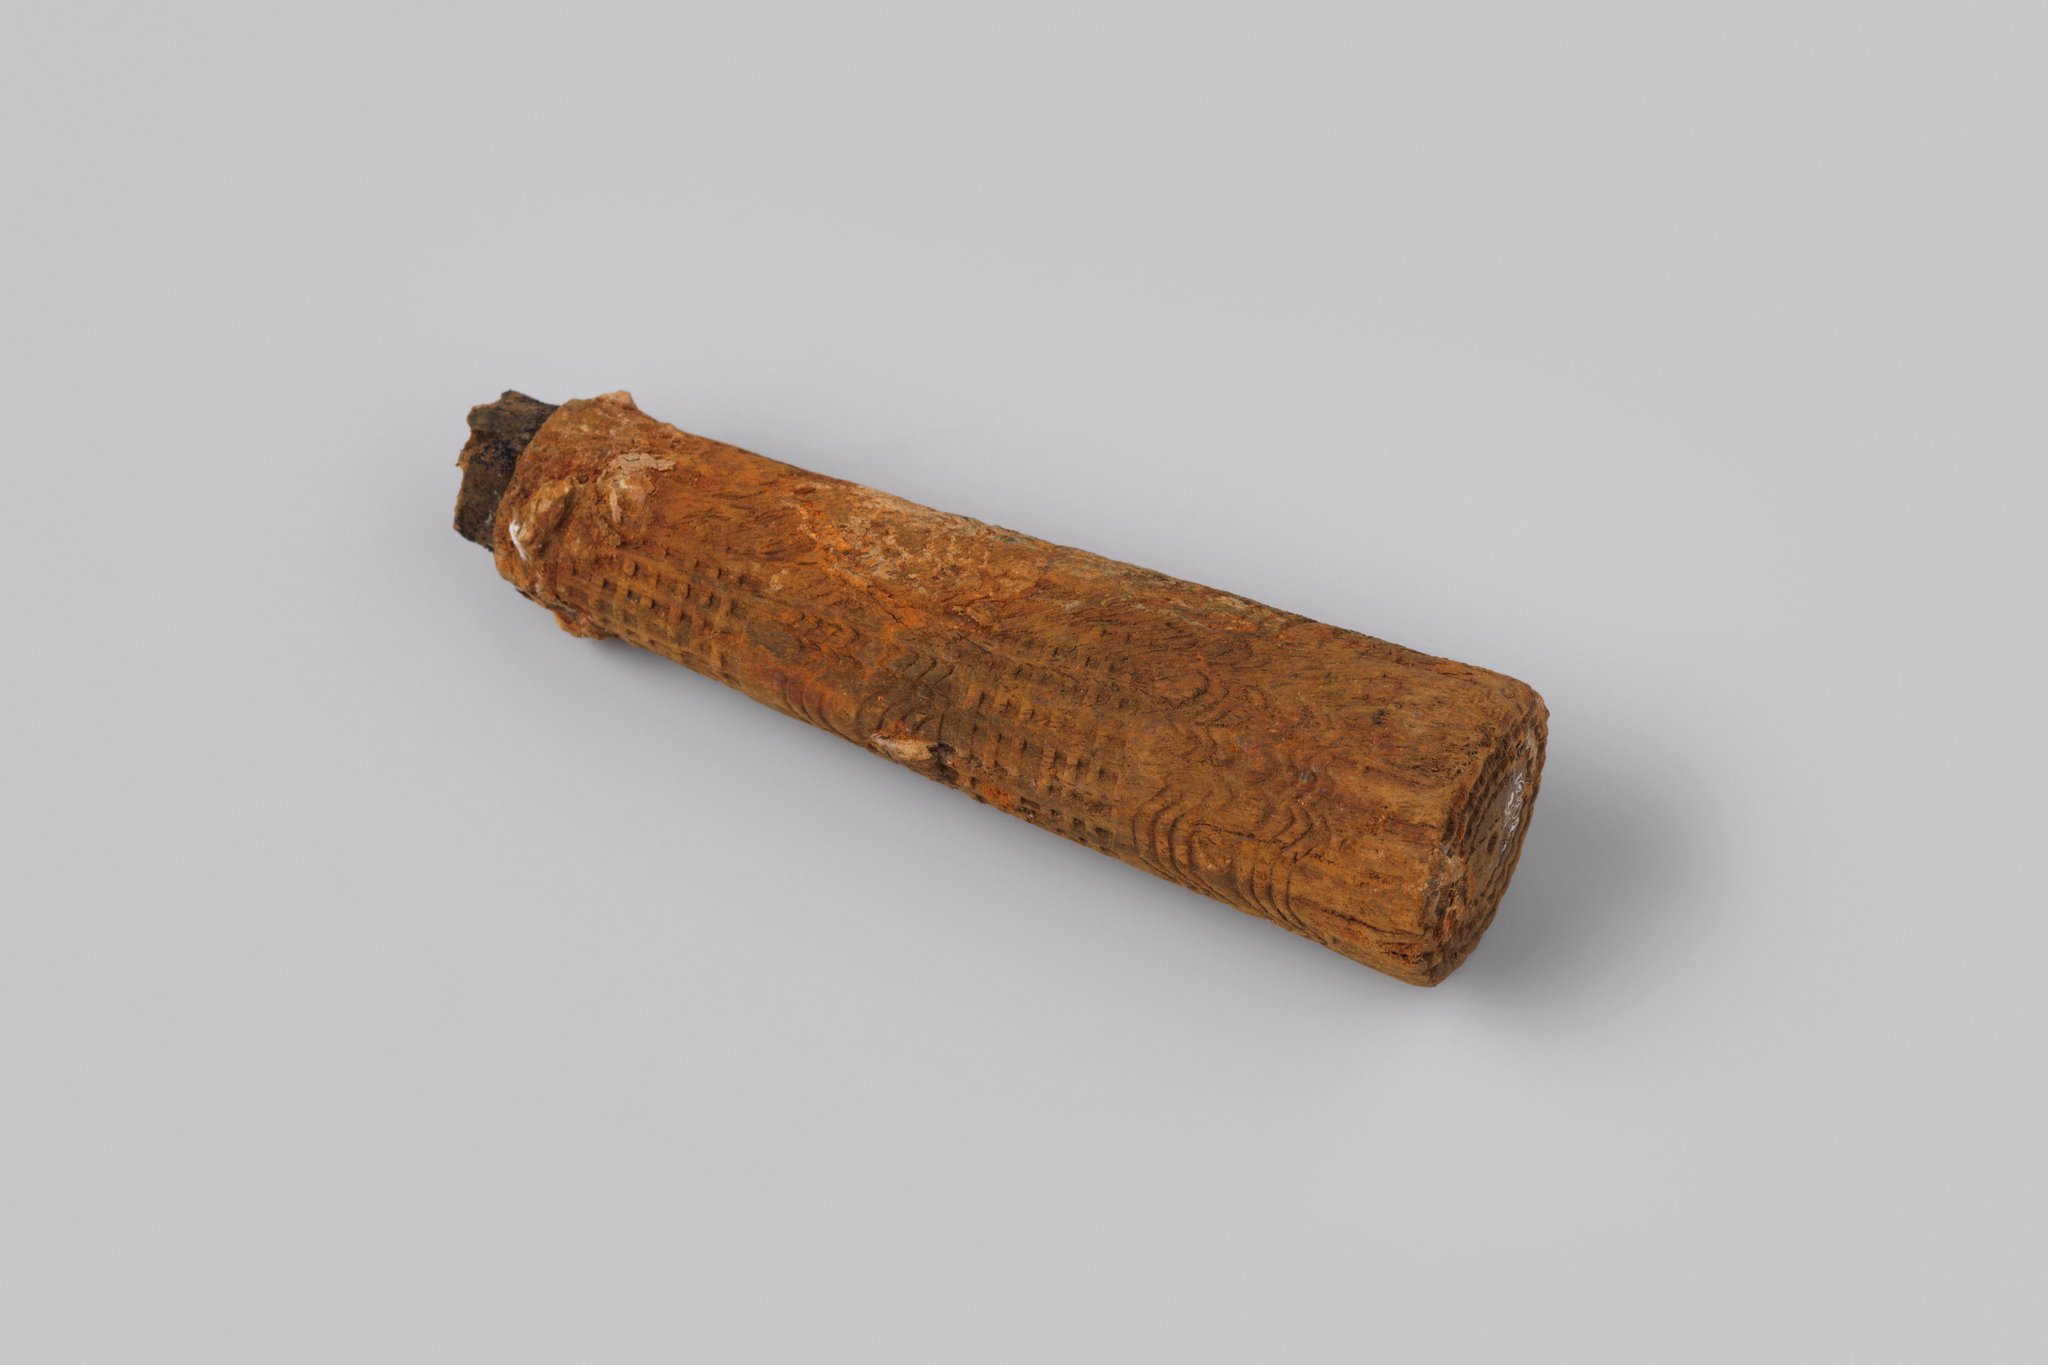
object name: knife handle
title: Messenheft uit het wrak van de Oost-Indiëvaarder Hollandia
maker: Anonymous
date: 1700-1743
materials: wood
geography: netherlands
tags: verenigde oostindische compagnie, hollandia (schip), annet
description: Knife, handle, cylindrical: tapering; id. NG 1979-403H, ferrules id. NG 1980-27H426.